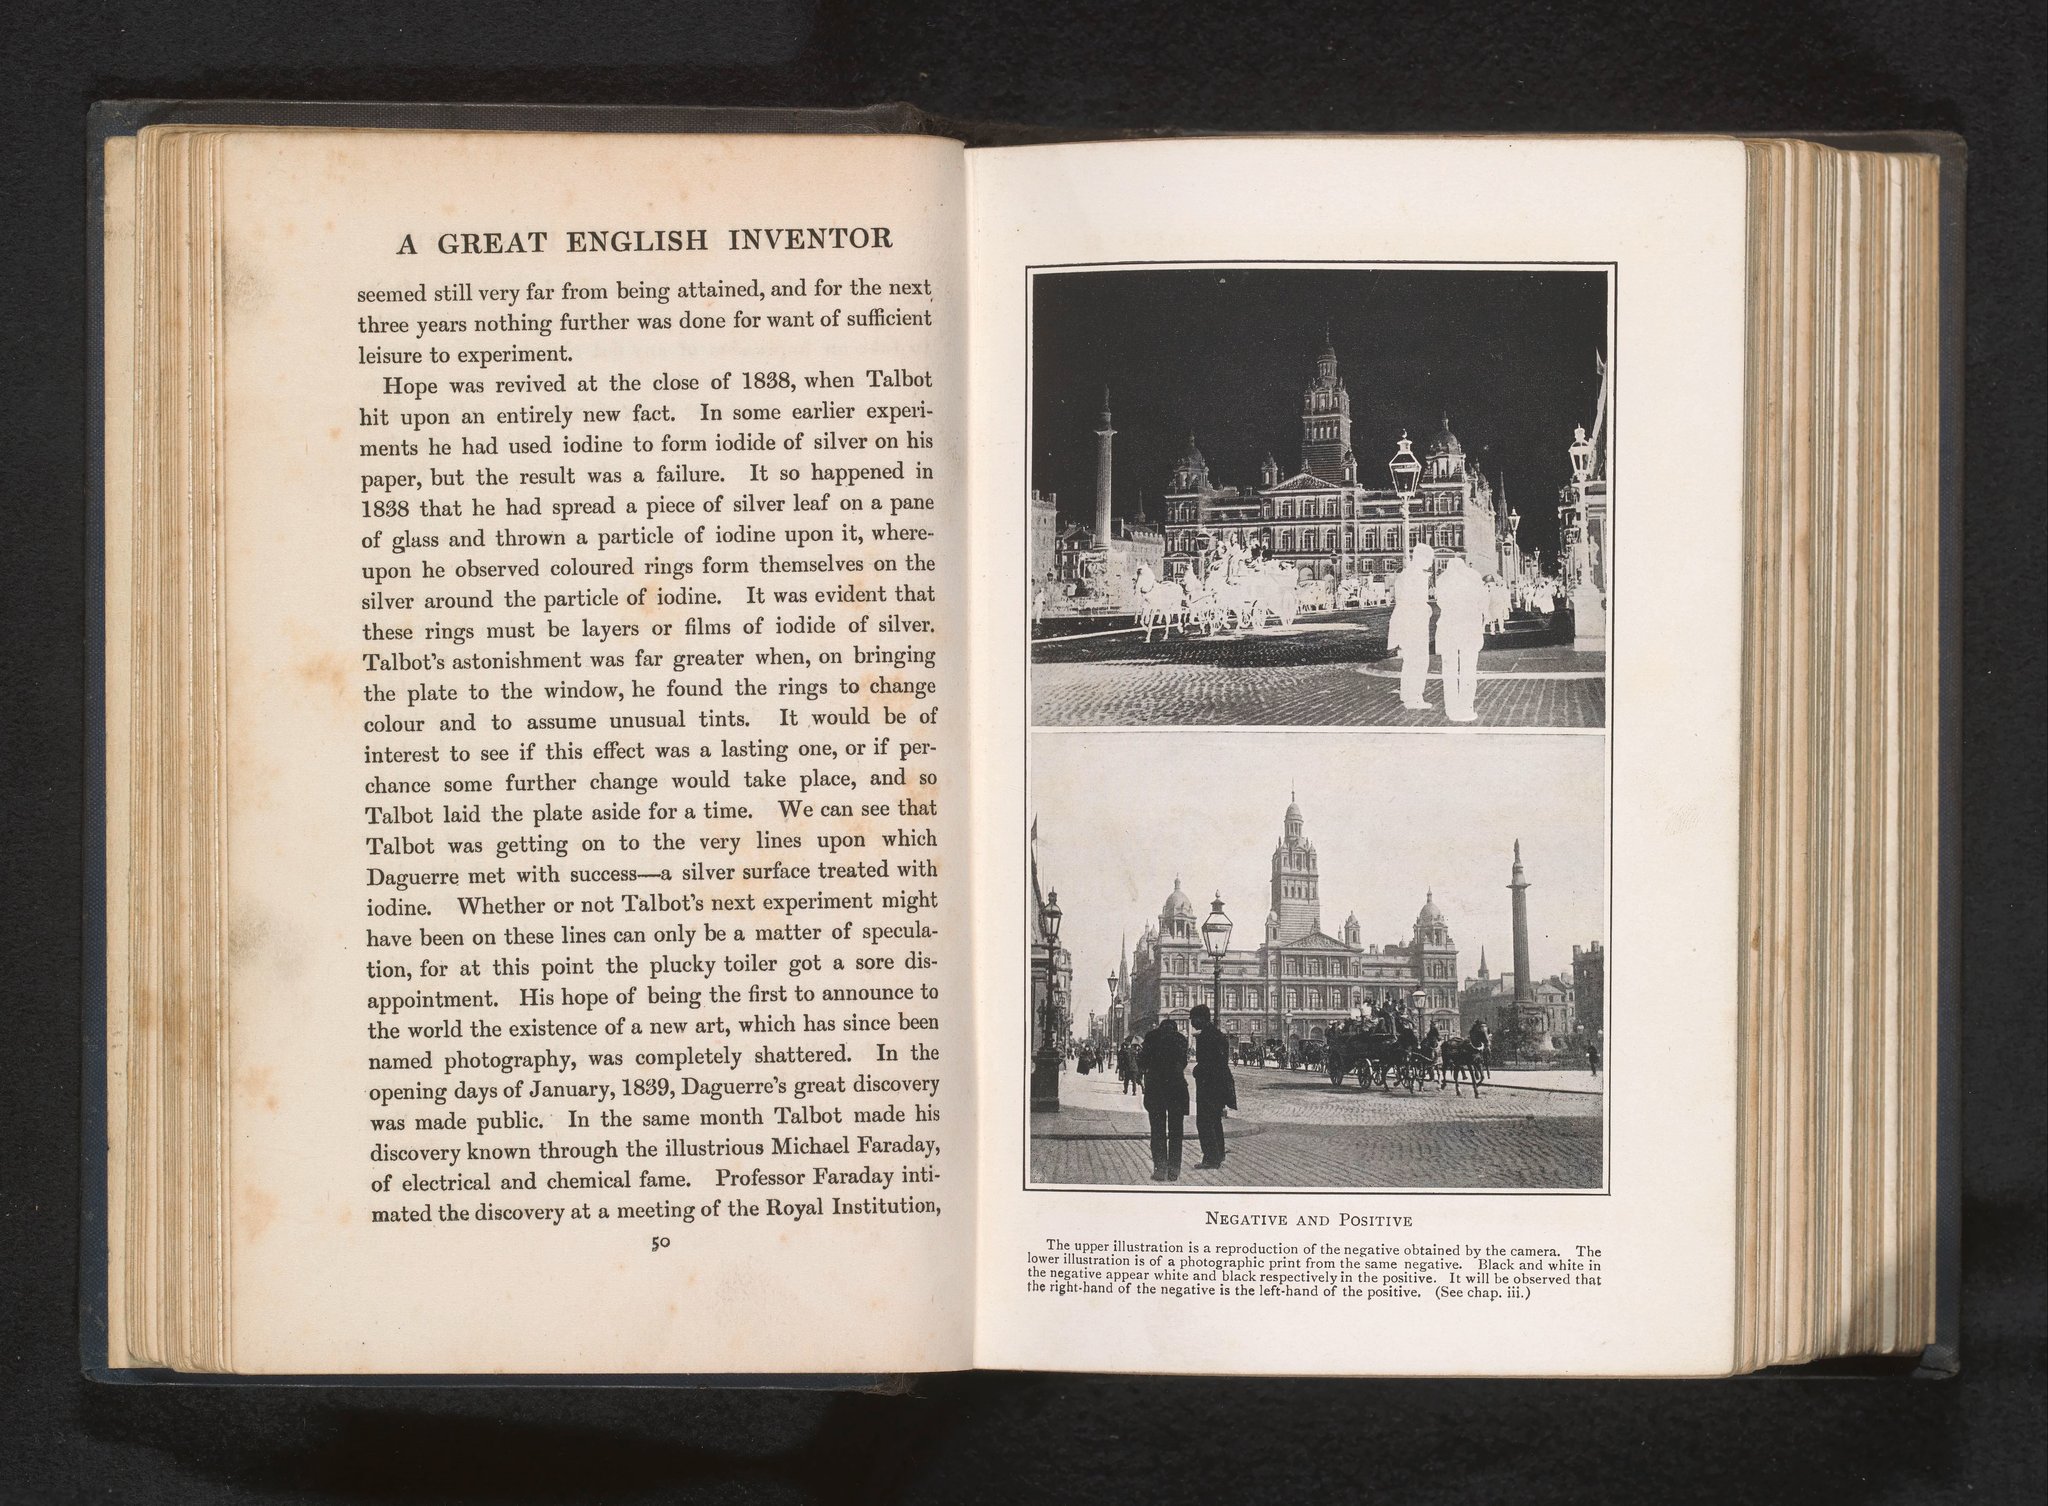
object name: photomechanical print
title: Negative and positive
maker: Anonymous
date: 1898-1908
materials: paper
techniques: autotype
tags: obelisk, needle, four-wheeled, animal-drawn vehicle, e.g.: cab, carriage, coach (+ conveyance for transport of persons)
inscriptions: inscription: ‘The upper illustration is a reproduction of the negative obtained by the camera. The lower illustration is a photographic print from the same nagative. Black and white in the negative appear white and black respectively in the possitive. It will be observed that the right-hand of the negative is the left-hand of the possitive. ( See chap. iii.)’